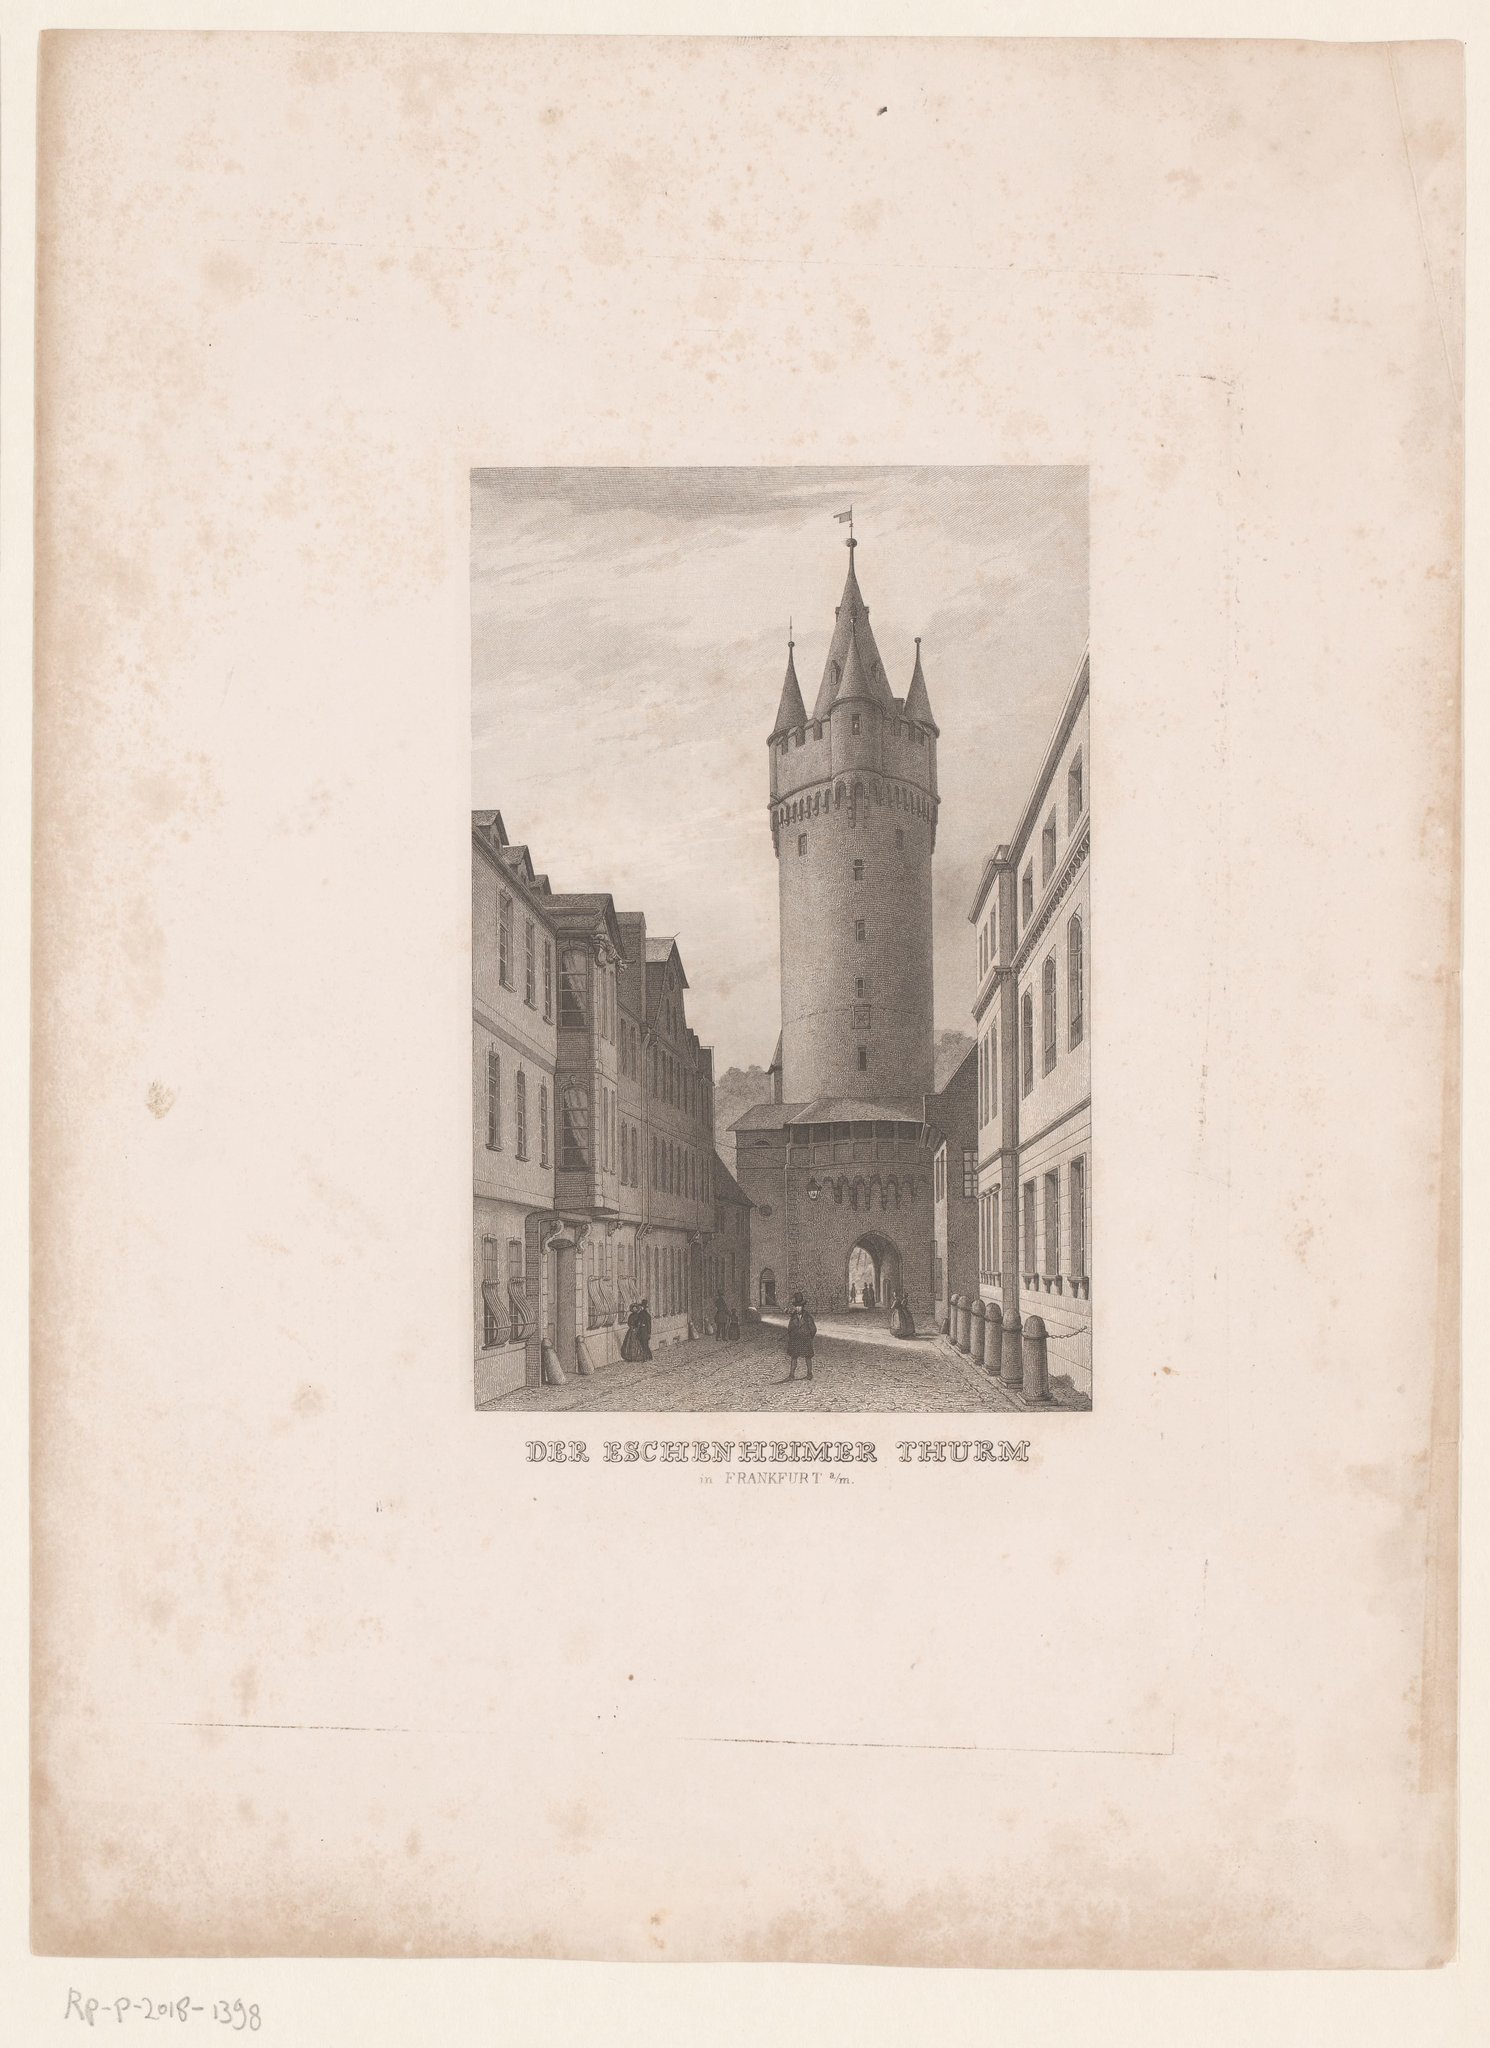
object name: print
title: Der Eschenheimer Thurm in Frankfurt a/m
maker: Anonymous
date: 1800-1899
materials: paper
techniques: etching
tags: towers ~ fortified city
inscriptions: collector's mark: Lugt 2228